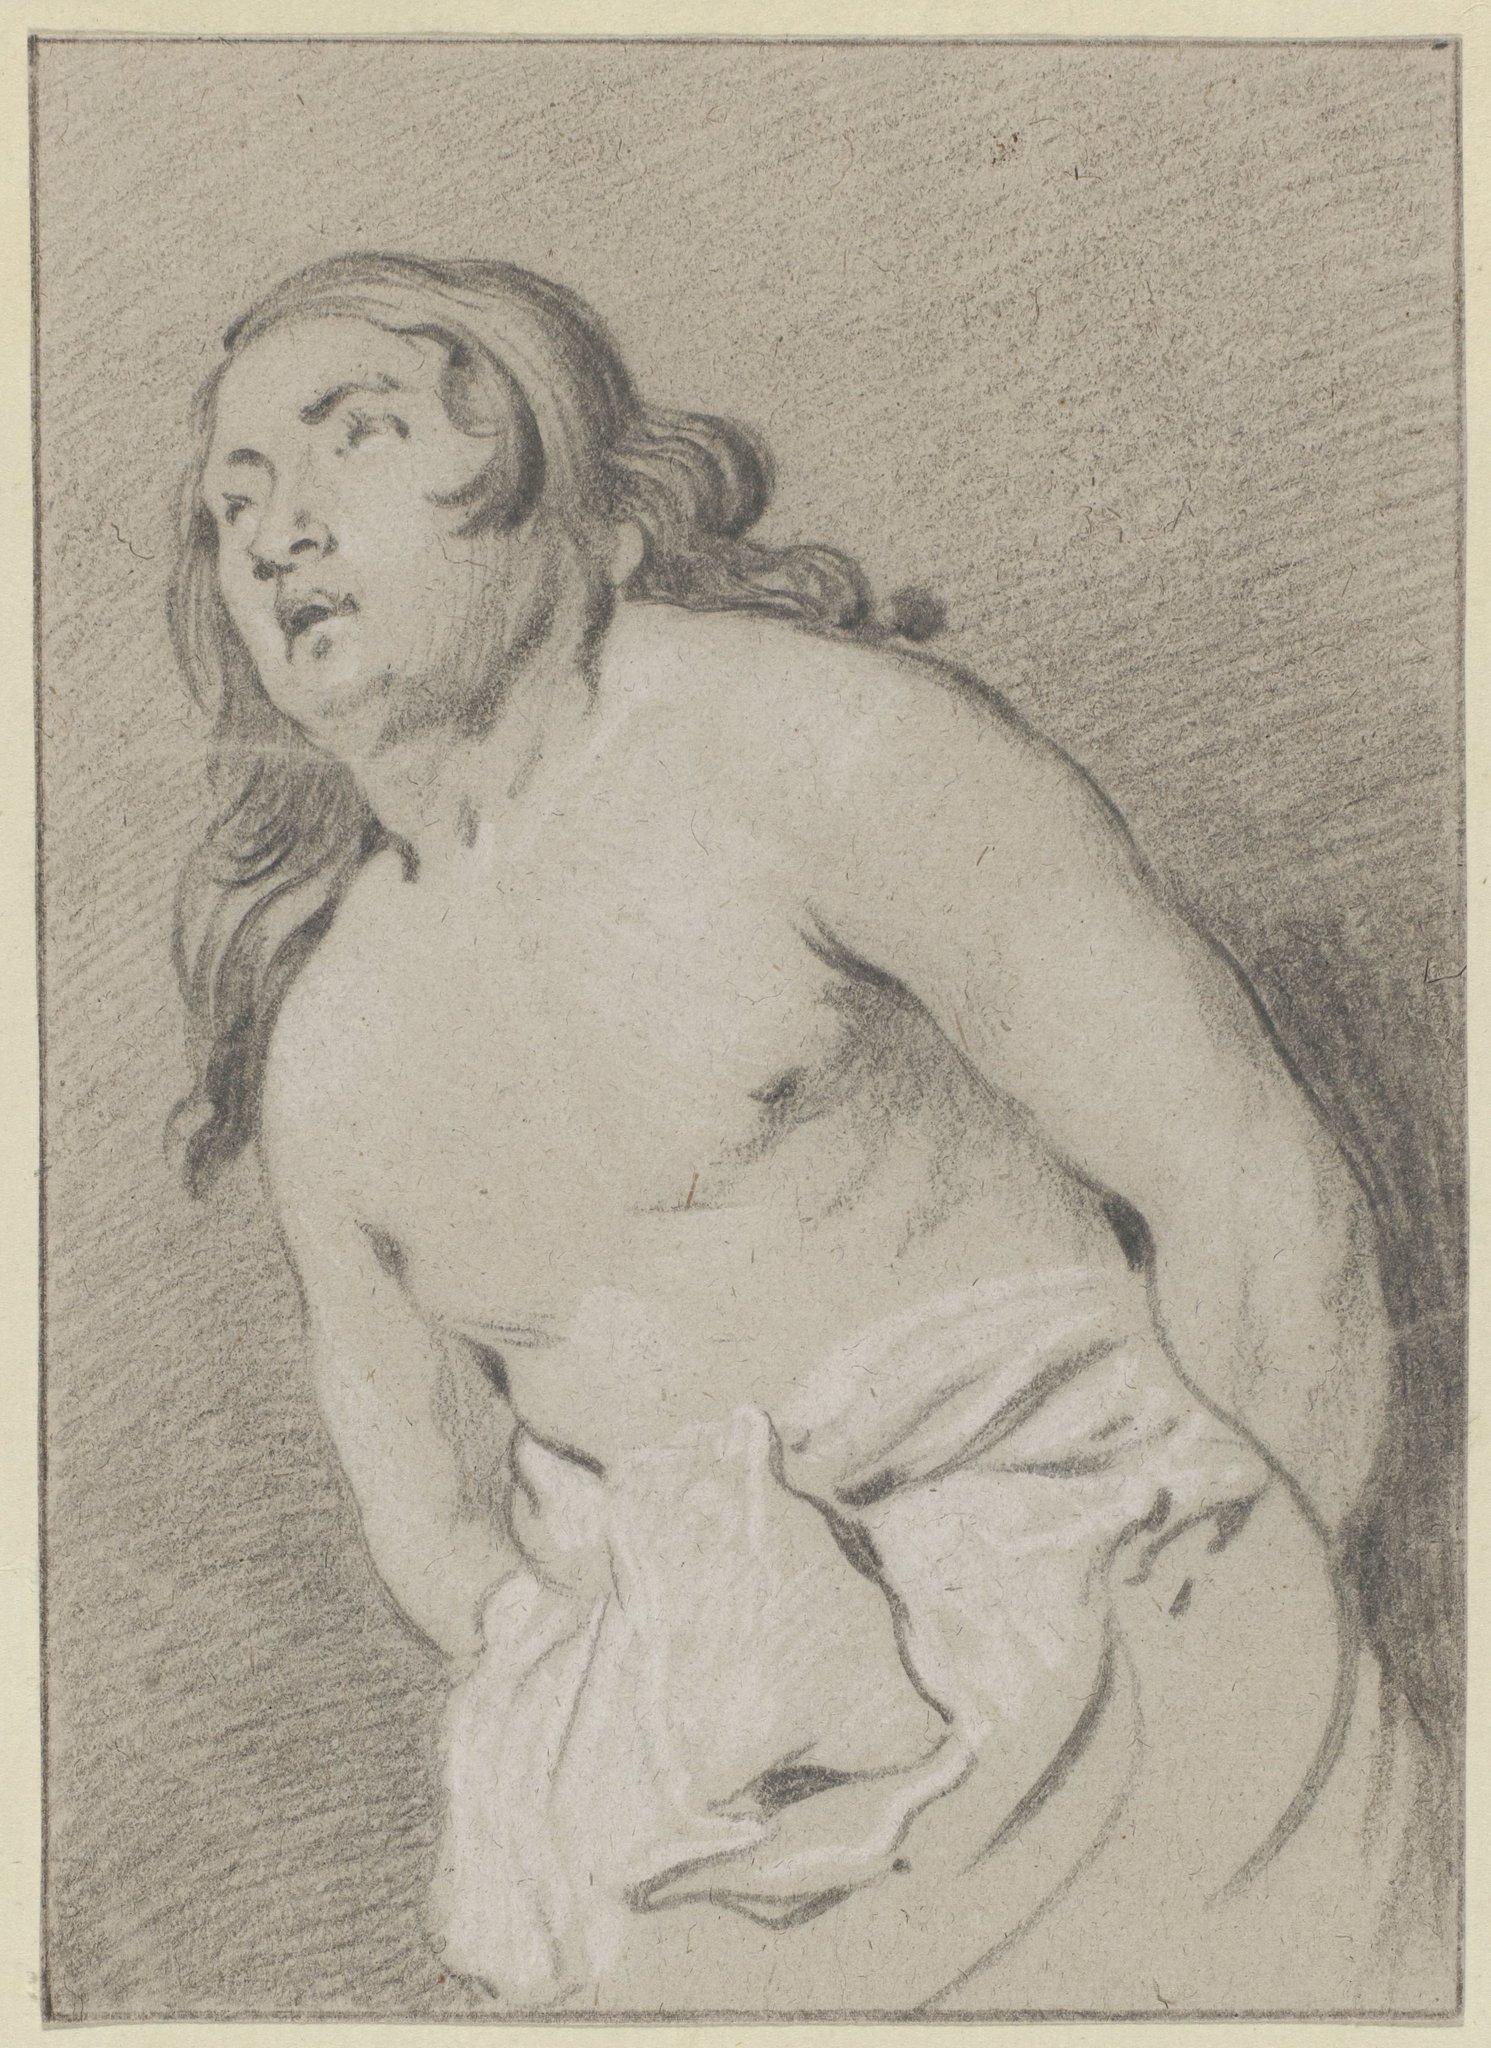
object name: drawing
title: Vrouw met ontbloot bovenlijf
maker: Anonymous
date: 1600-1699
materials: chalk, paper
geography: netherlands